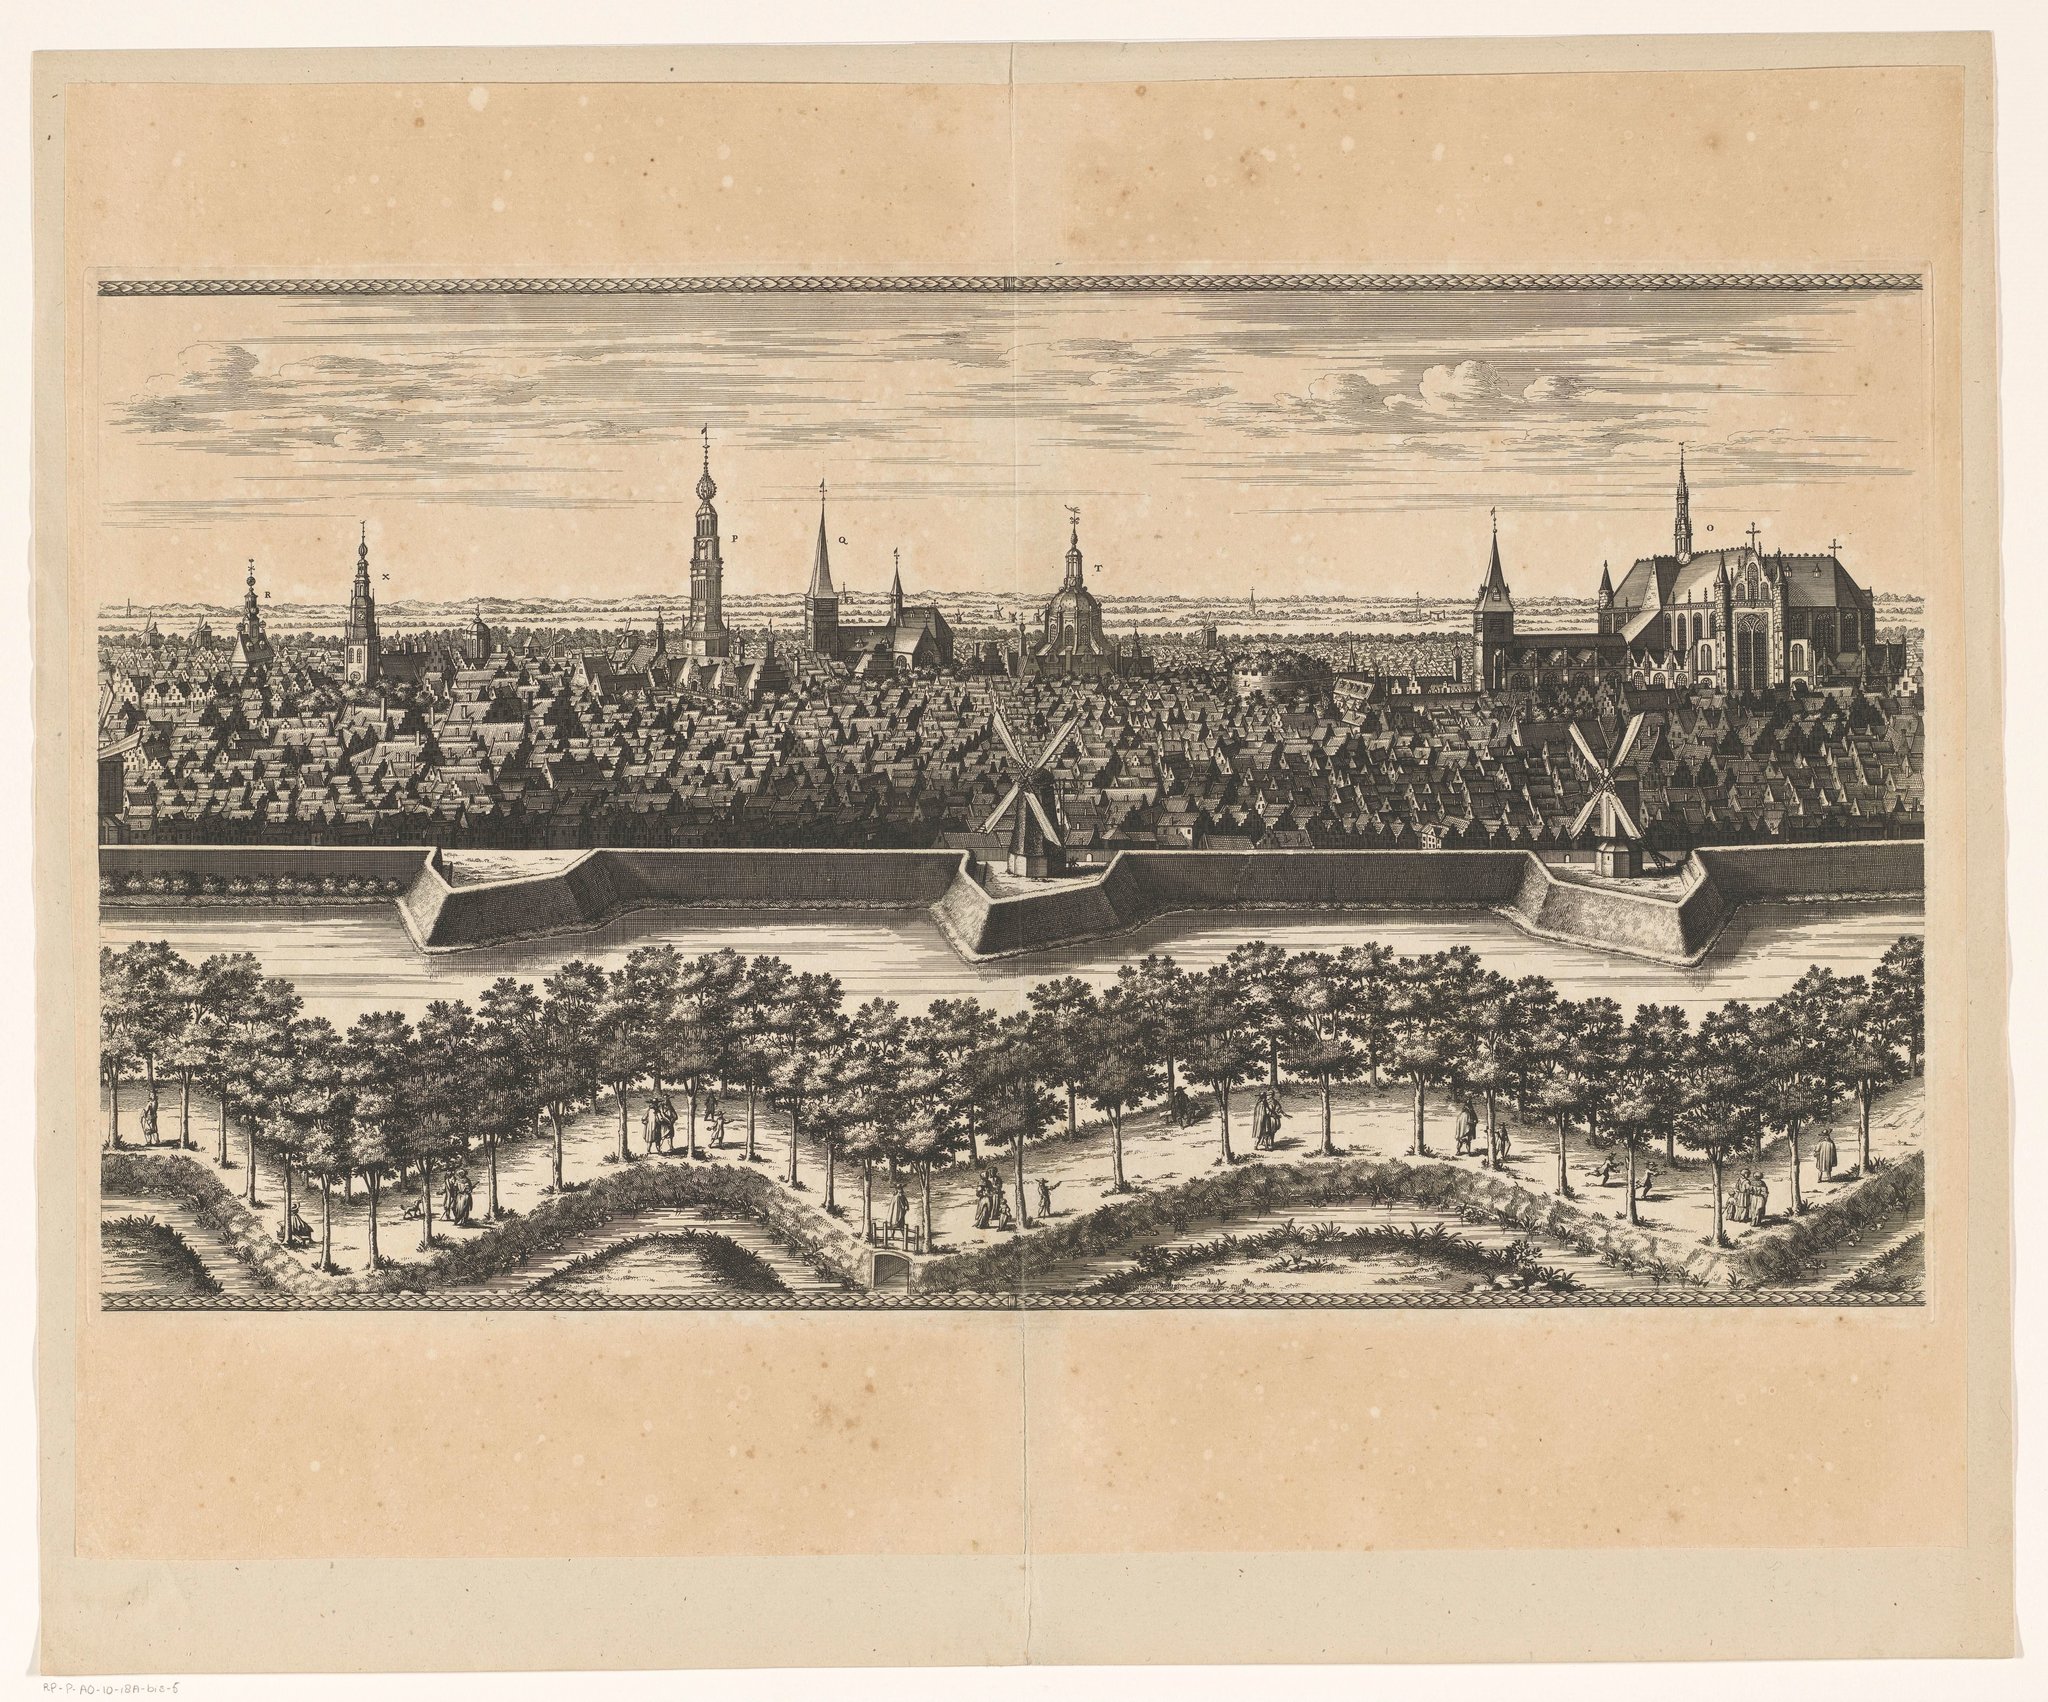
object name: print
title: Lugdunum Batavorum ANo 1670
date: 1675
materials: paper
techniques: engraving, etching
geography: amsterdam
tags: prospect of city, town panorama, silhouette of city, leiden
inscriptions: collector's mark: Lugt 2228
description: Deze prent is oorspronkelijk bedoeld als onderdeel van de rand van de zogenaamde Grote Hagen, een wandkaart van Leiden uit 1675. Deze wandkaart bestaat uit een plattegrond van Leiden met daaromheen een rand (met boven de titel en de wapens van de stad en de burgemeesters, langs de zijkanten afbeeldingen van gebouwen in de stad en onder een stadsprofiel). De plattegrond is gedrukt van vier platen, de rand van veertien. Hoewel het jaartal 1670 in de titel staat en de wapens aan de bovenkant van de vier in 1670 zittende burgemeesters zijn, blijkt uit archiefonderzoek dat deze wandkaart pas in 1675 voor het eerst is gedrukt en uitgegeven (zie documentatie voor meer informatie). Voor een digitaal gemonteerde versie van de hele rand zie koepelrecord. Voor een digitaal gemonteerde versie van de bovenkant van de rand zie RP-P-AO-10-18A-A. Voor een digitaal gemonteerde versie van de onderkant van de rand zie RP-P-AO-10-18A-B. Voor een digitaal gemonteerde versie van een latere druk van de plattegrond zie RP-P-AO-10-18. Voor een digitaal gemonteerde versie van de Kleine Hagen zie RP-P-AO-10-81.